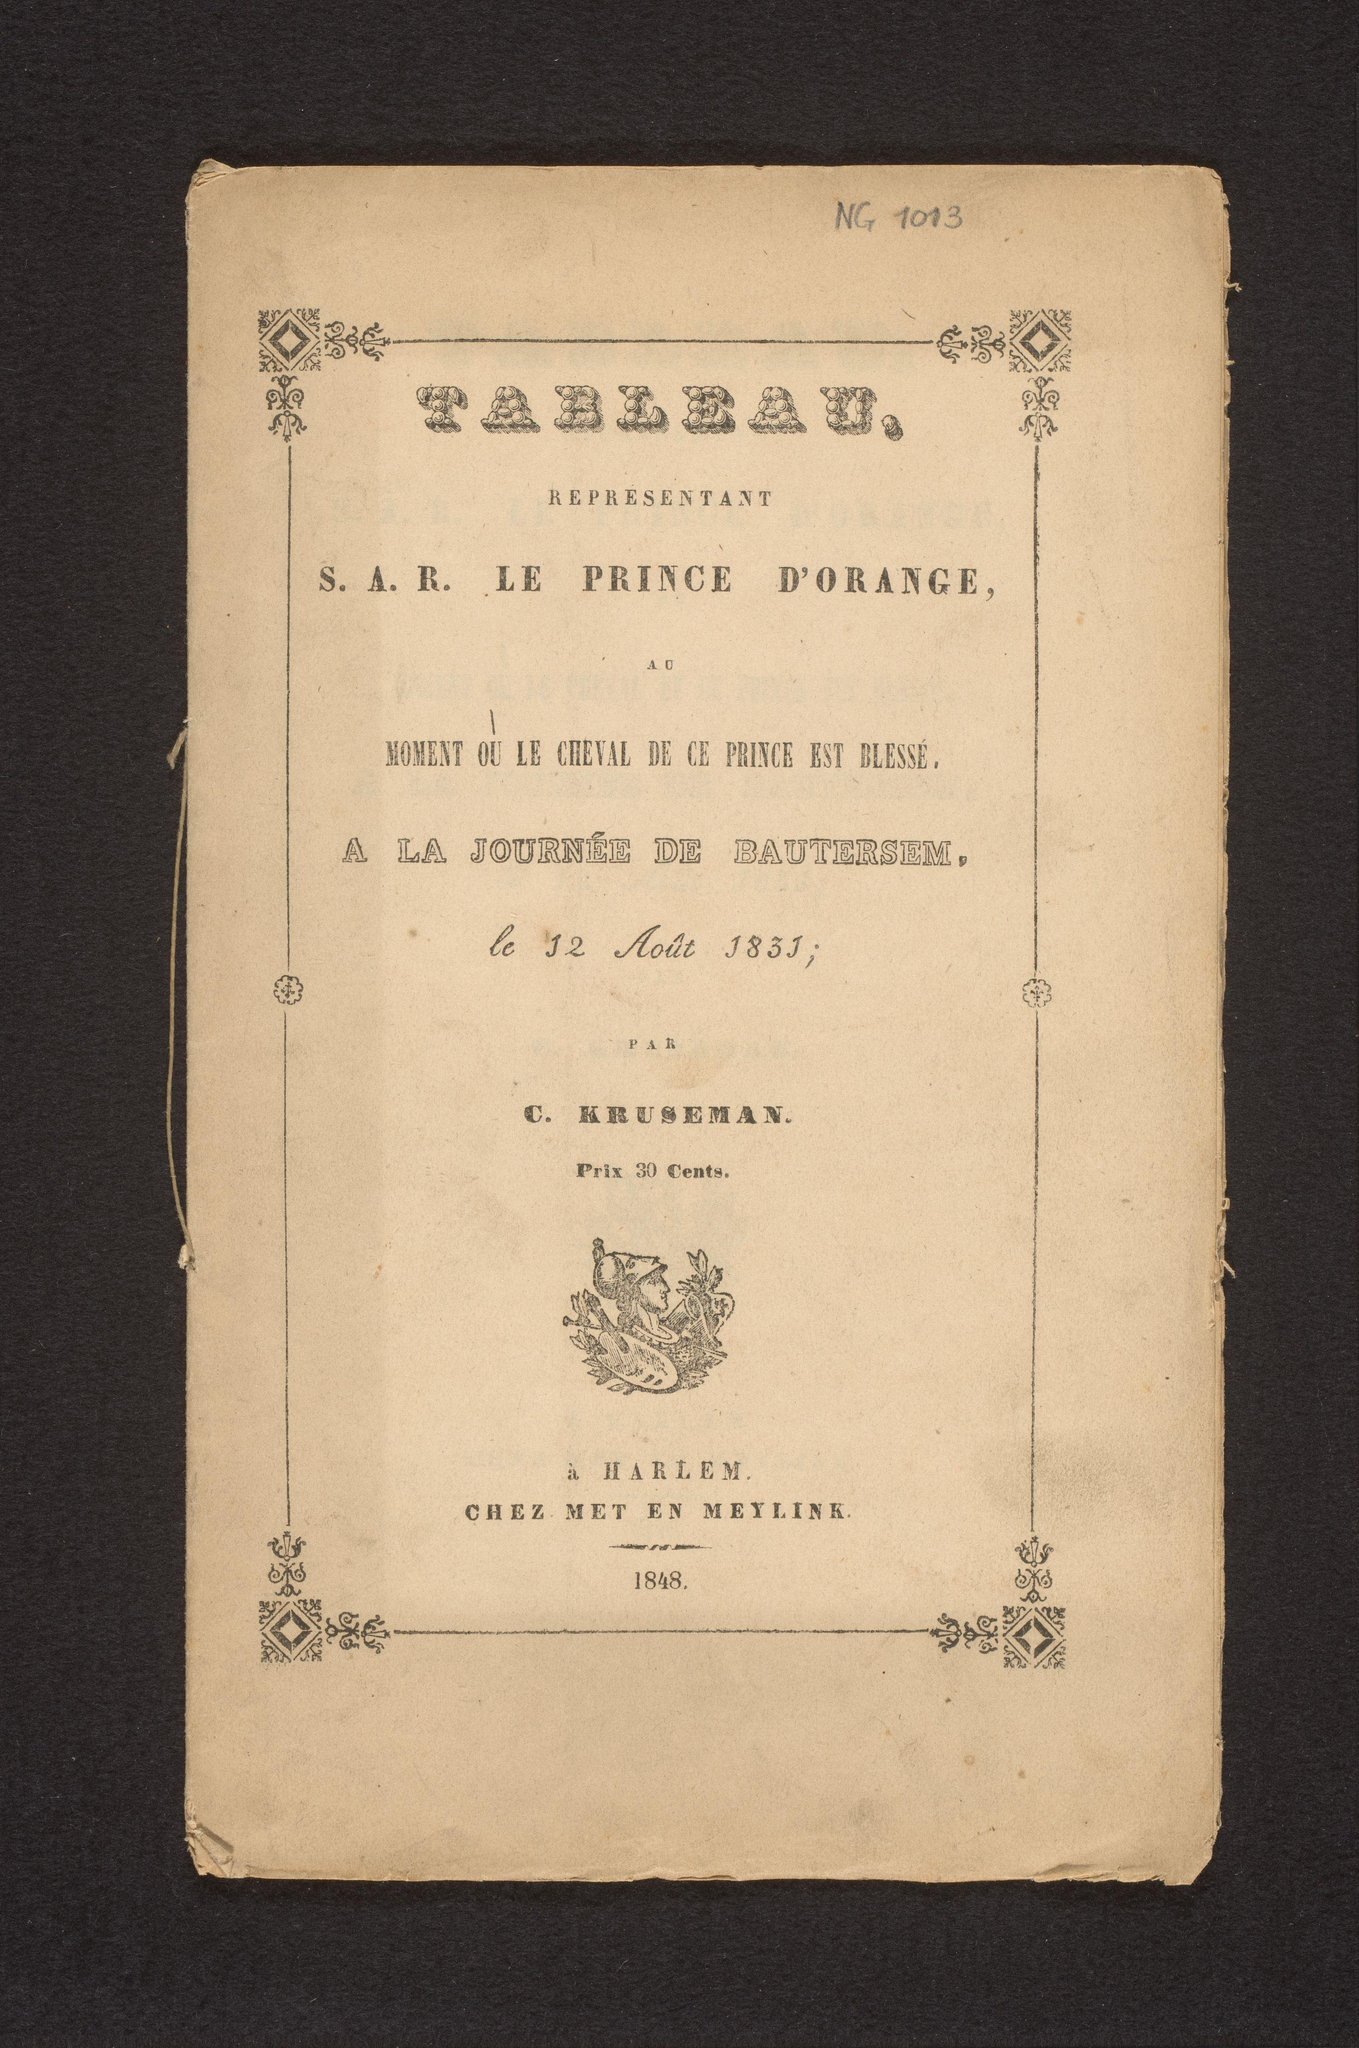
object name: brochure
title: Tableau, representant S.A.R. le Prince de'Orange au moment ou le cheval de ce prince est blessé, a la journée de Bautersem...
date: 1848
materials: paper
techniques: printing, sewing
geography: haarlem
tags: boutersem, slag bij boutersem, belgische revolutie, tiendaagse veldtocht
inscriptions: date